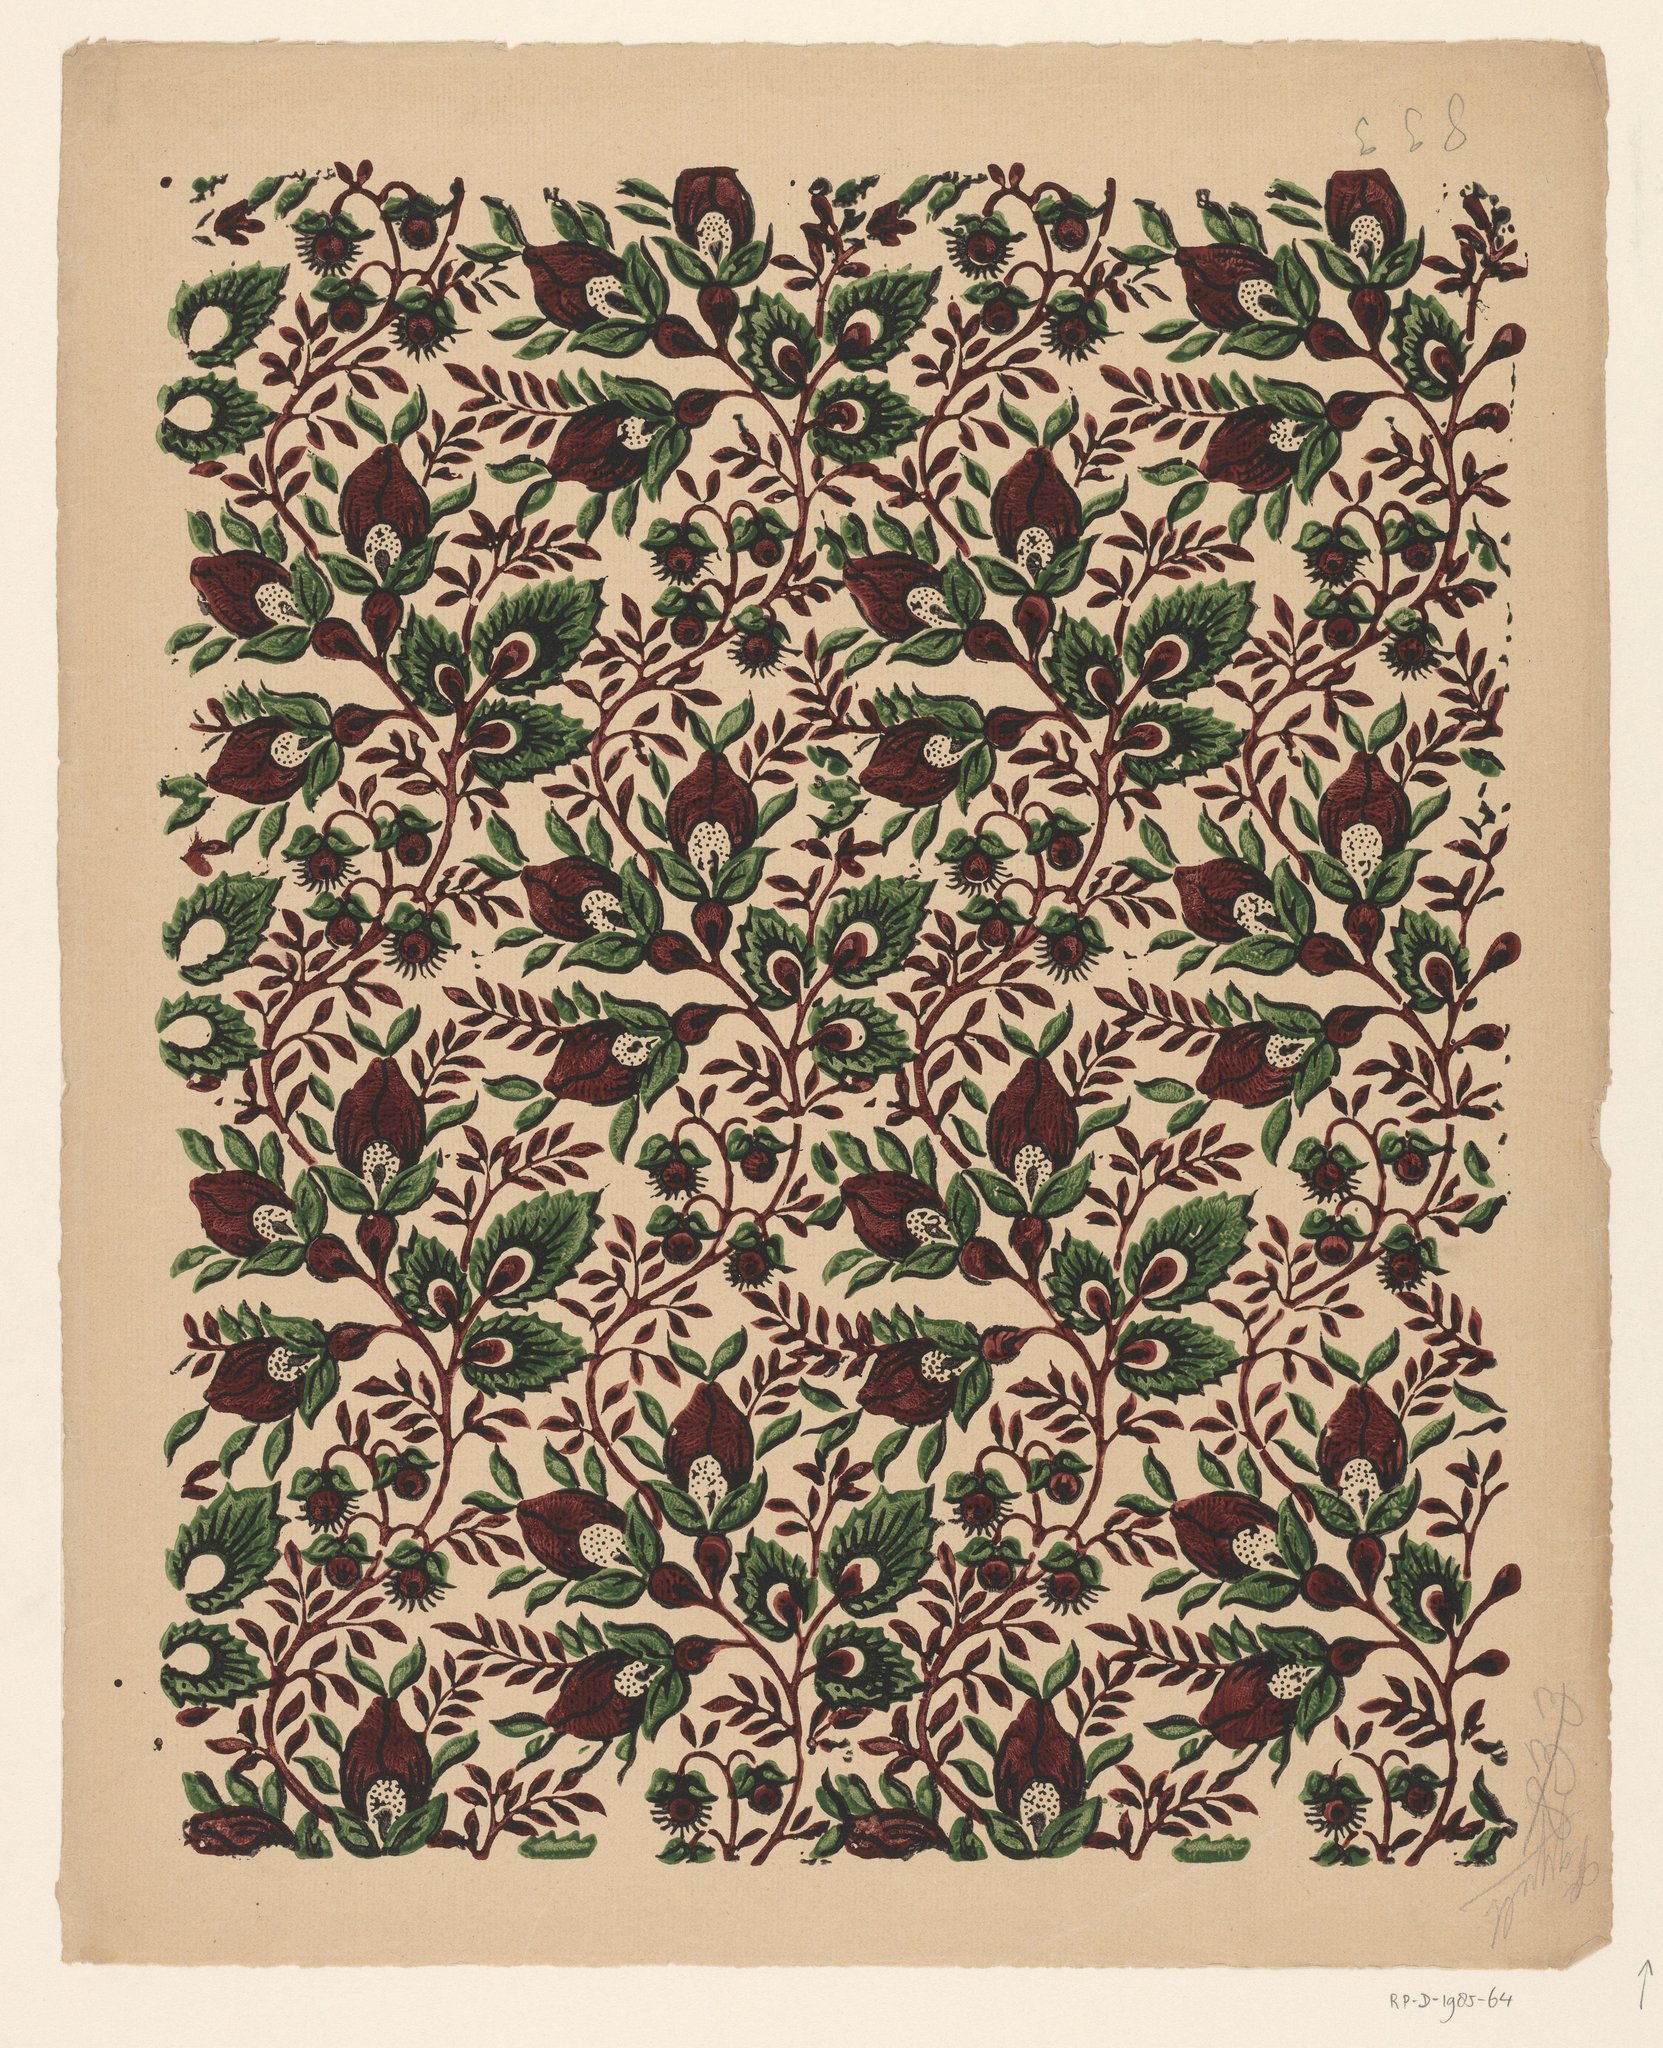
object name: printed paper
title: Blad met patroon van slingerende ranken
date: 1861-1939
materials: paper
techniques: printing block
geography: italy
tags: ornament derived from plant forms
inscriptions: annotation: ‘given by Wartsh 1982’, collector's mark: Lugt 2228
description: Blad met patroon van vier verticaal slingerende ranken met bladeren, bloemen en vruchten.